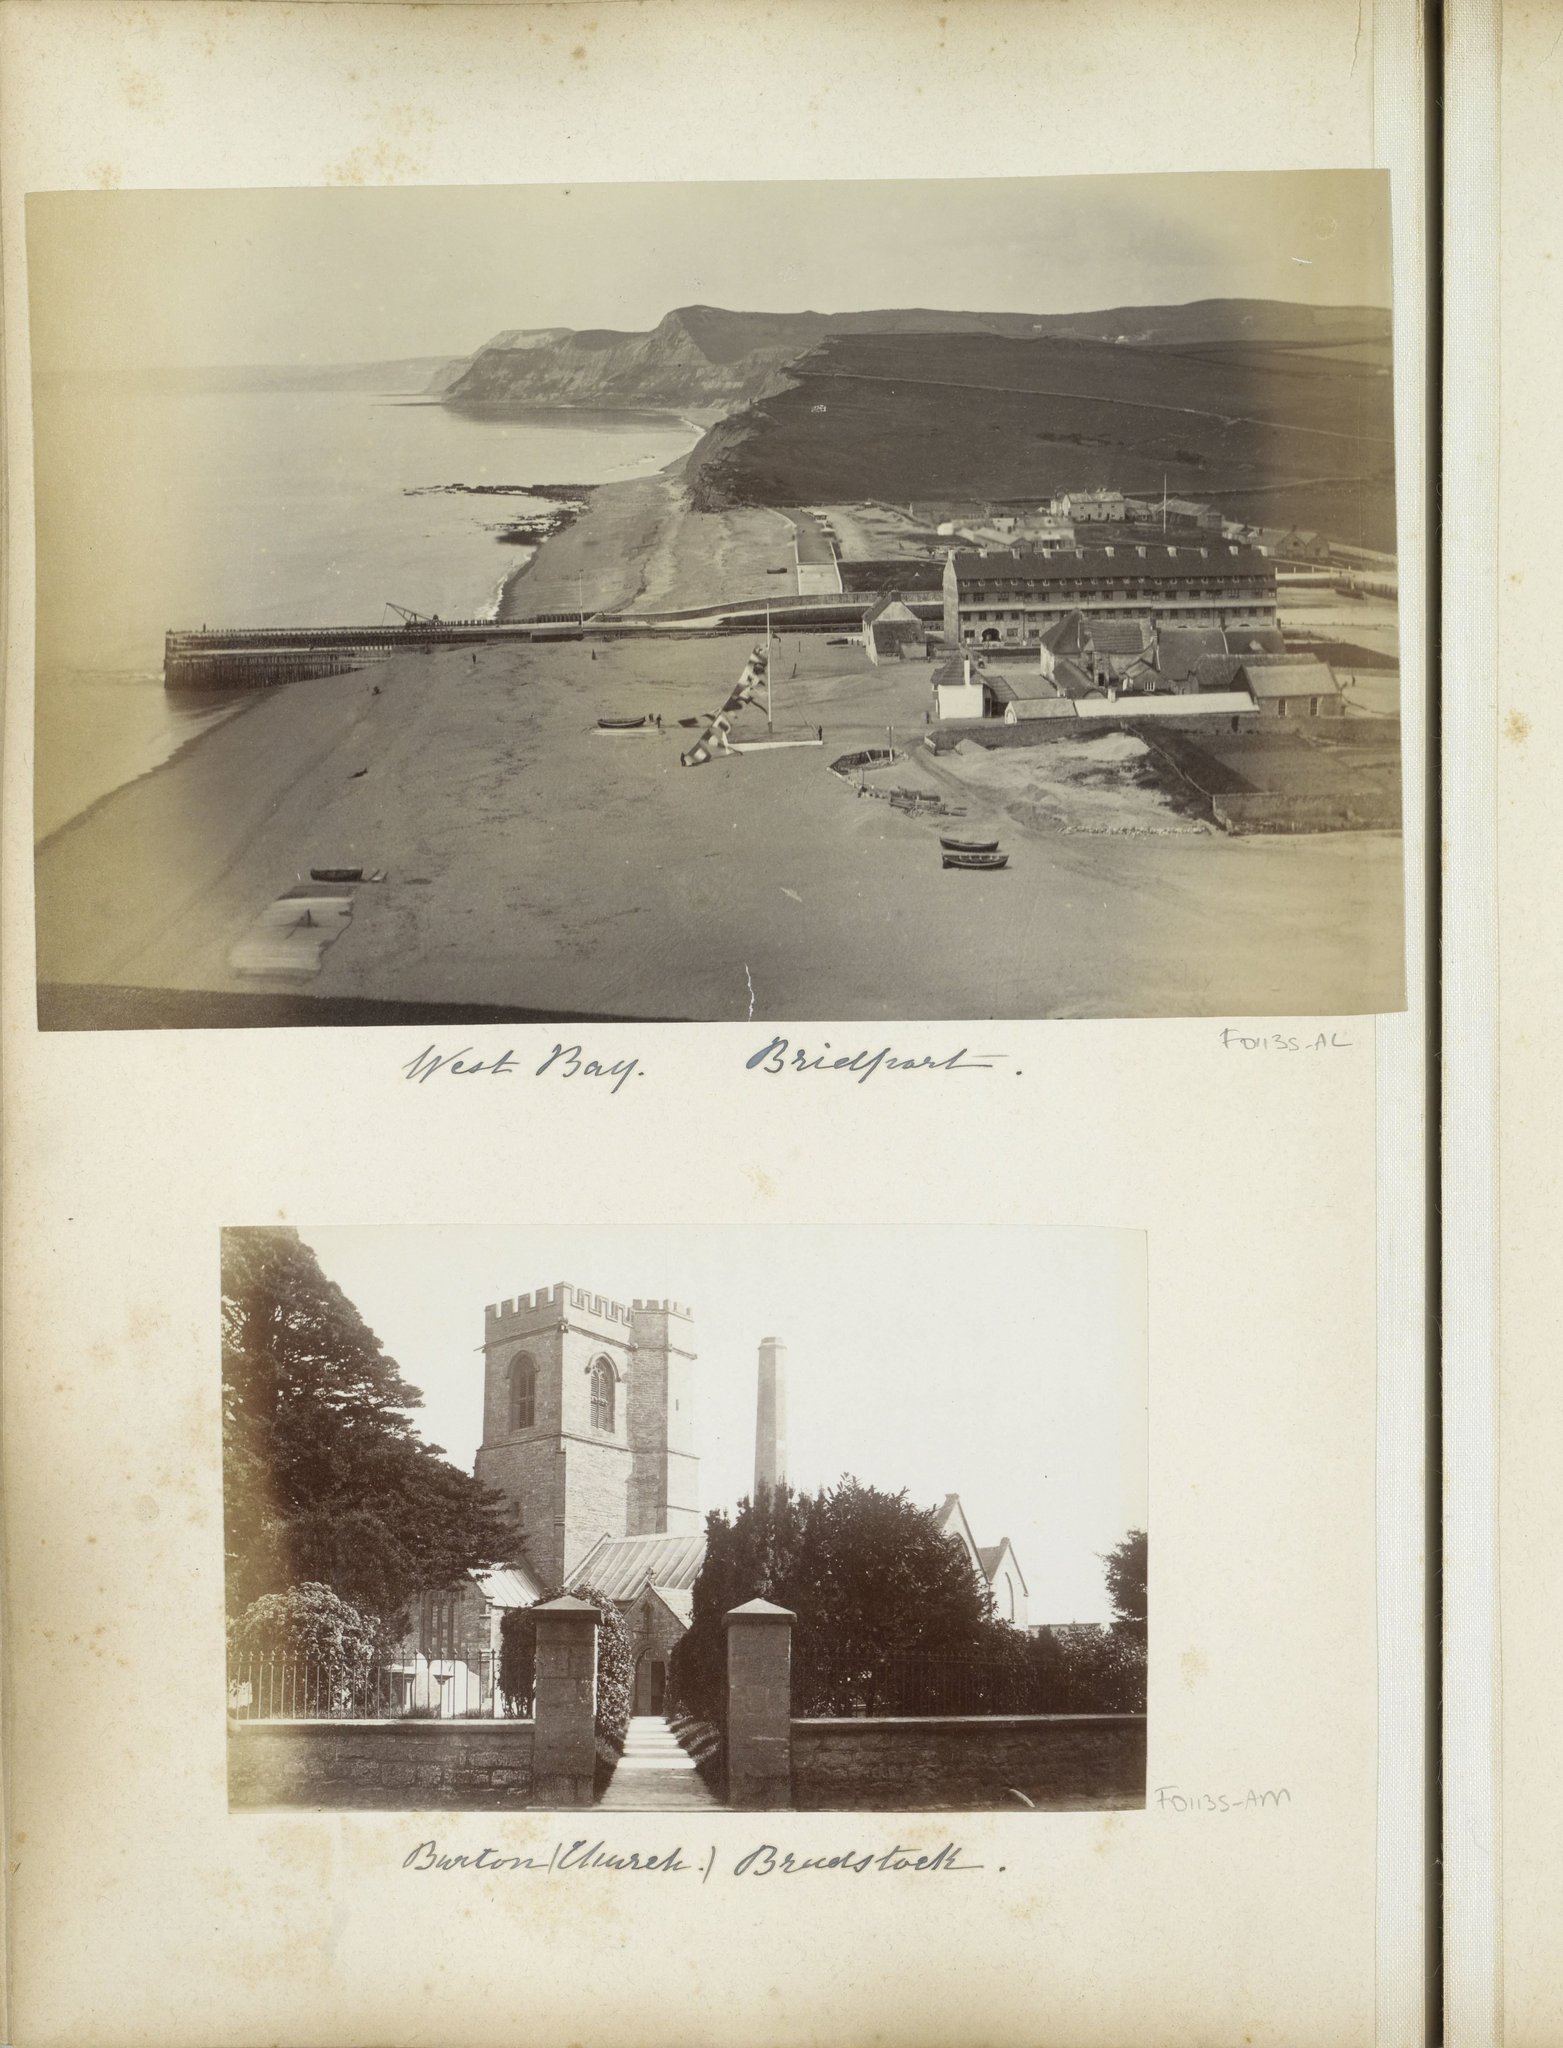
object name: album leaf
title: Exterieur van St Mary's Church in Burton Bradstock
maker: Anonymous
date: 1898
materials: paper, photographic support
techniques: albumen print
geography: burton bradstock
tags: church (exterior), churchyard, cemetery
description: Onderdeel van Reisalbum met foto's van bezienswaardigheden in Engeland en Frankrijk.